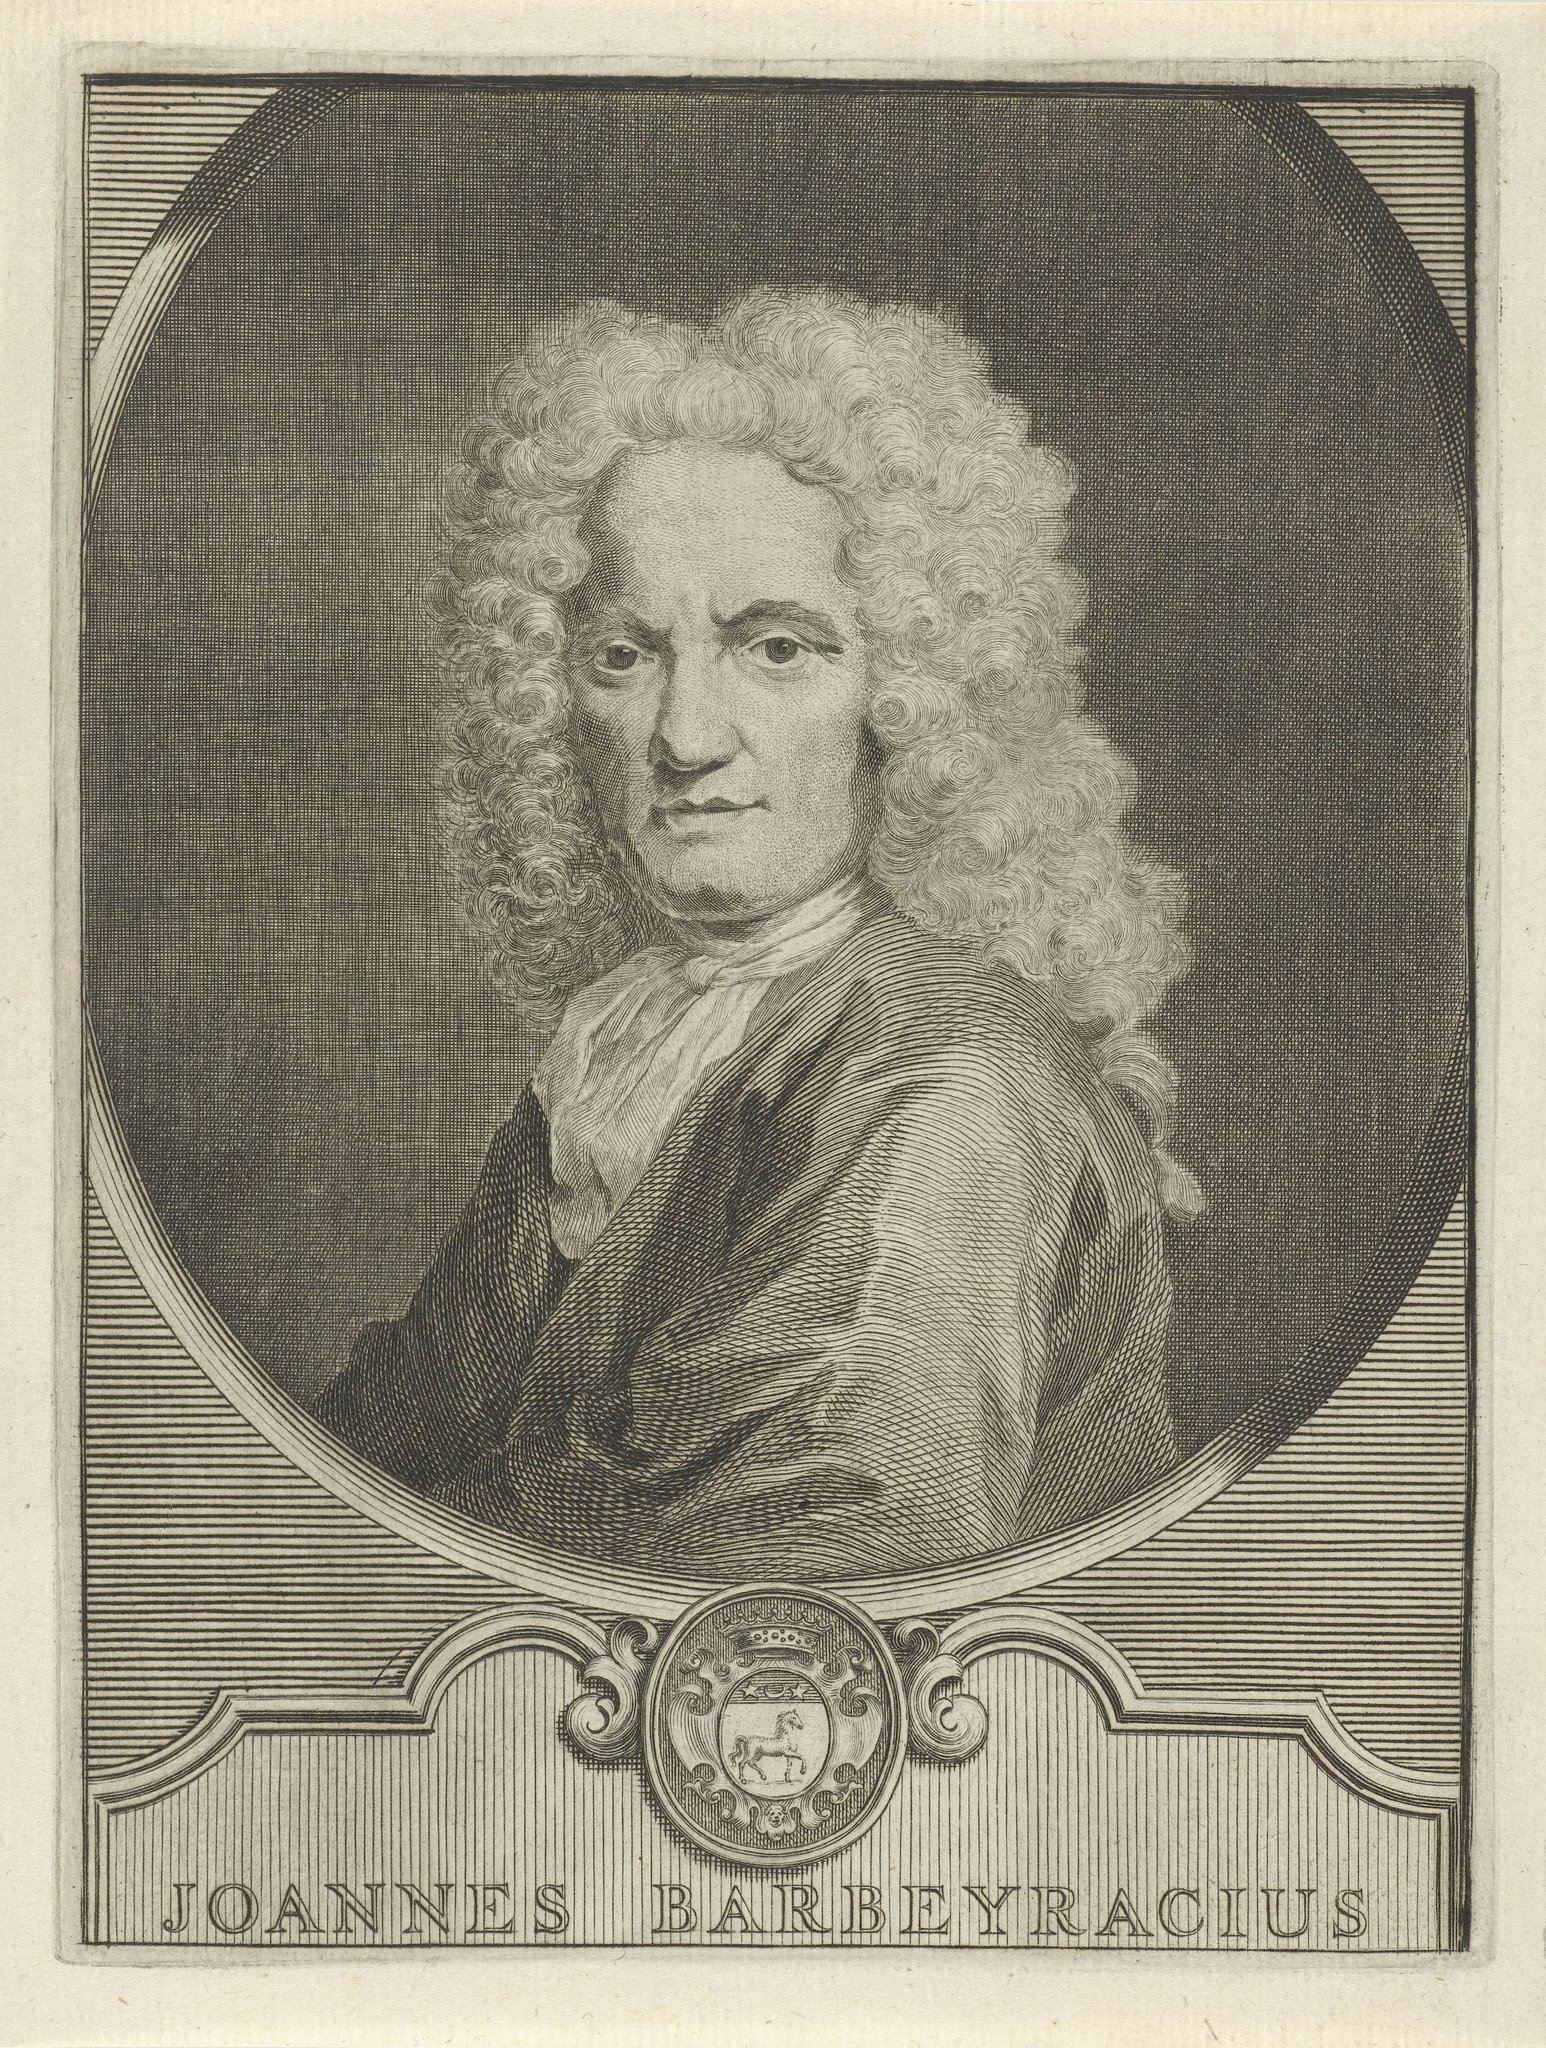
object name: print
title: Portret van Jean Barbeyrac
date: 1717-1744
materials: paper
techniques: engraving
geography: amsterdam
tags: béziers, groningen, predikant, hoogleraar, jurist, jean barbeyrac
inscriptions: collector's mark: Lugt 215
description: Buste naar links van Jean Barbeyrac in een ovaal. Onder het portret zijn wapen en zijn naam.